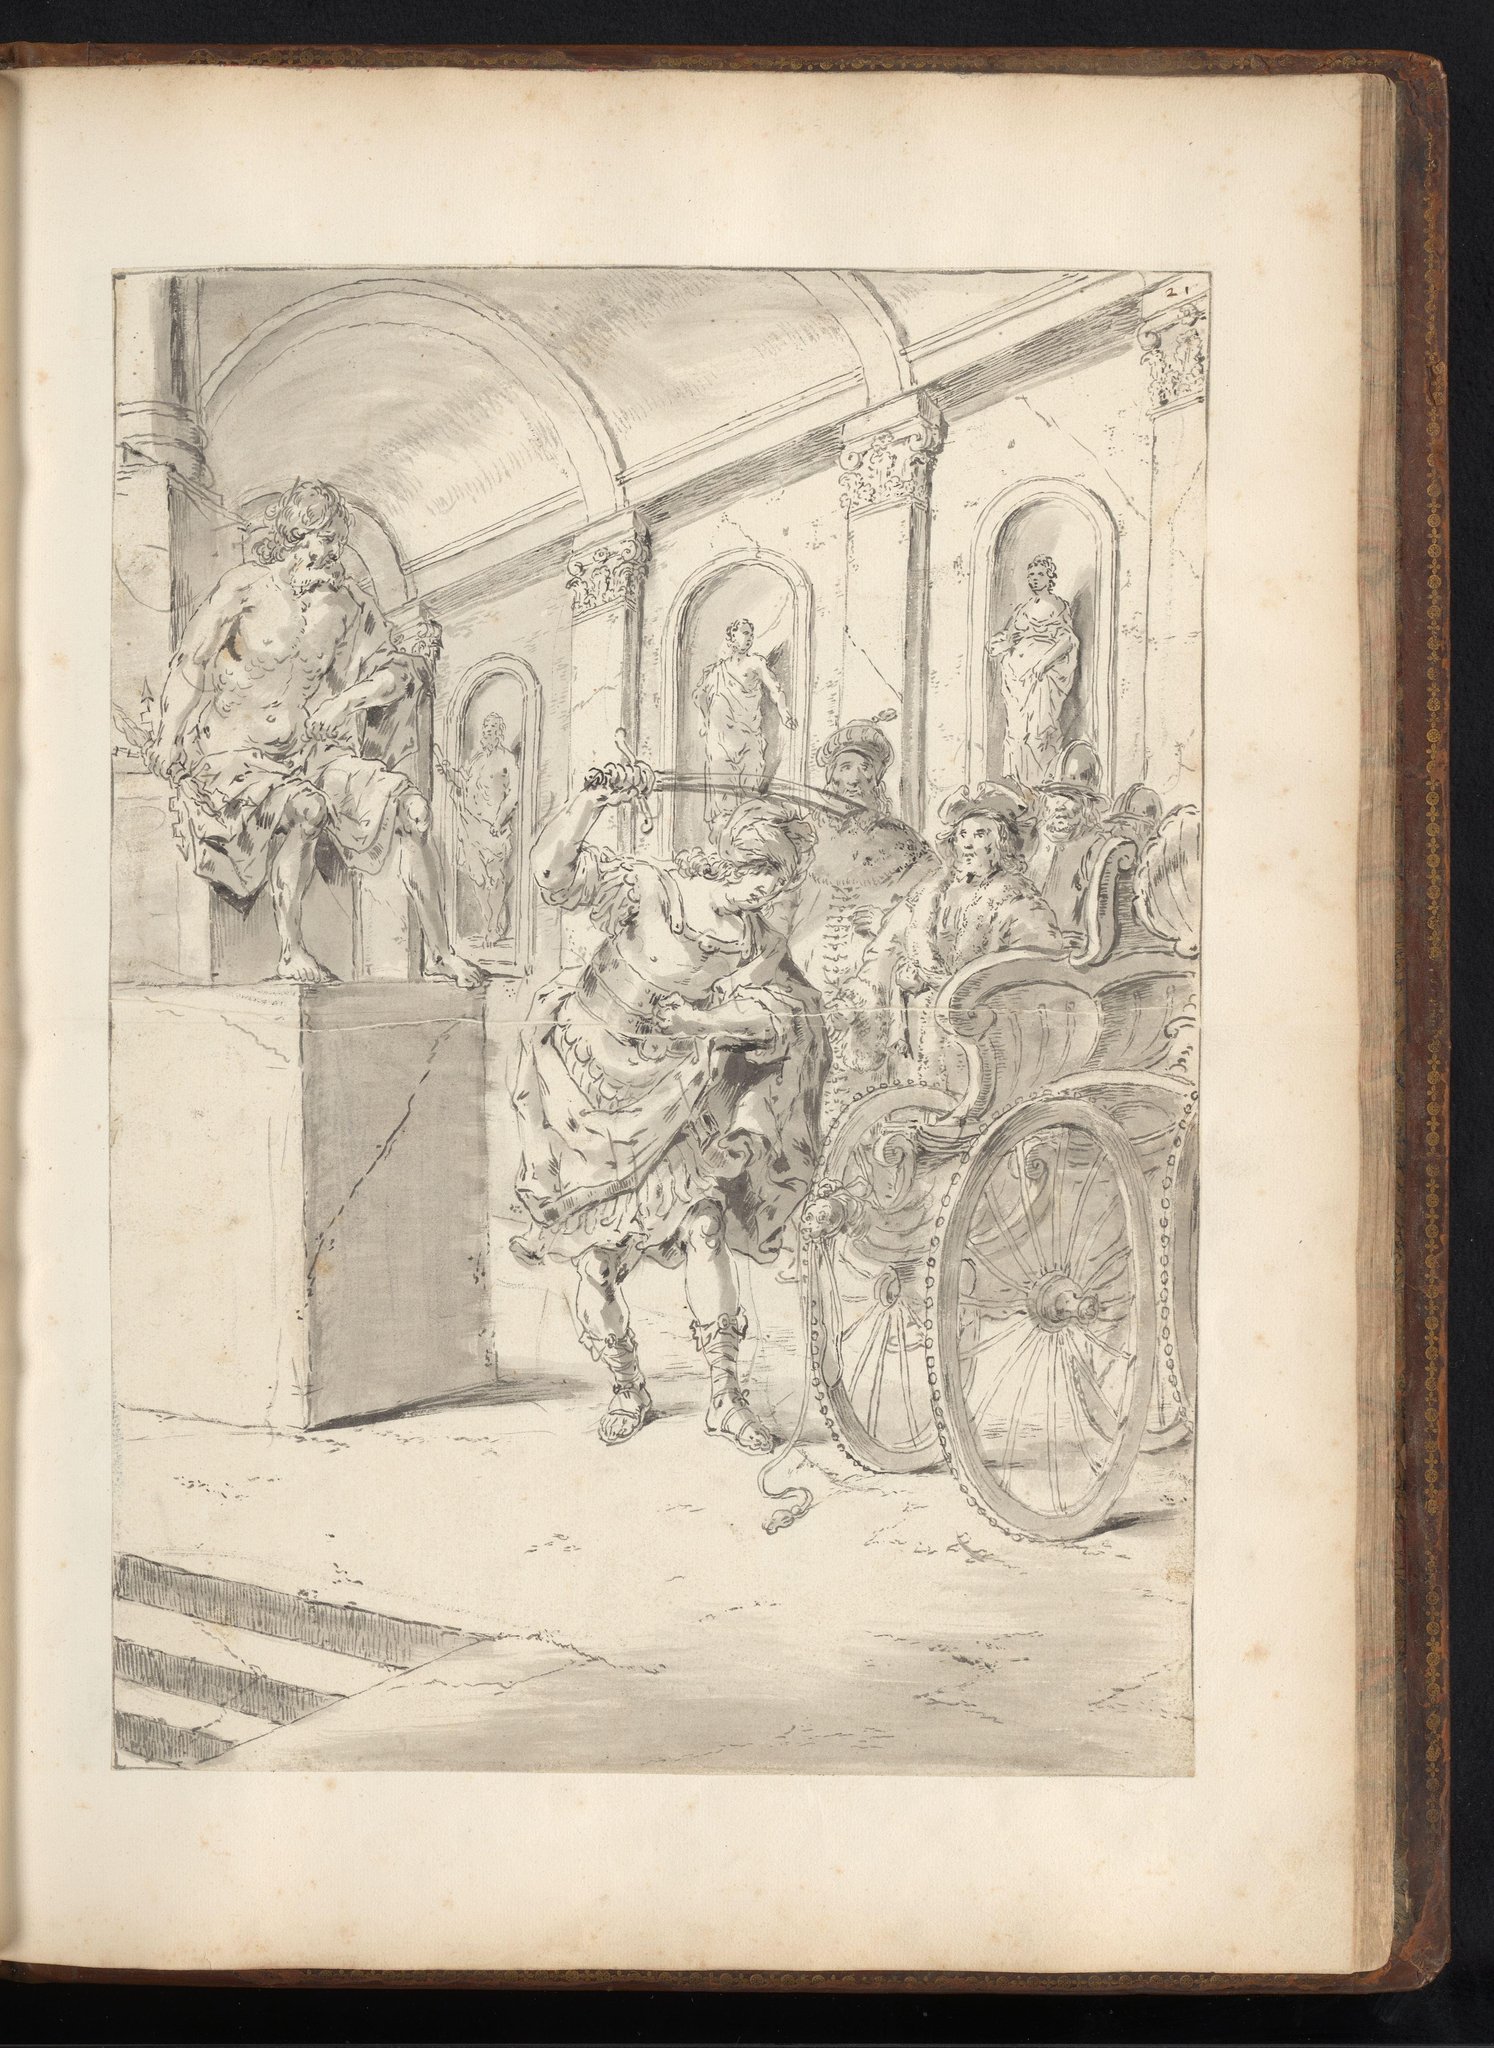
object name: album leaf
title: Vint in den tempel van Jupiter tot Gordien den wagen aan den welcken de knoop vast gemaackt was, daarmen van schreef, die desen los conde doen de ganse wereld soude besitten niet conende doen, clooftse met sijn swaart overmidt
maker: leonaert bramer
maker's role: draughtsman, painter, print maker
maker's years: 1596-1674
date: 1655-1665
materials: ink, paper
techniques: brush, pen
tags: alexander cuts the gordian knot with his sword, (story of) jupiter (zeus)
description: Alexander de Grote staat in het midden, op het punt om de Gordiaanse knoop doormidden te hakken. Op een verhoging links zit de god Jupiter. Nadat Alexander de Grote de stad Gordium had ingenomen kwam hij in de tempel van Jupiter waar zich de wagen van Gordias bevond. De dissel van de wagen was vastgemaakt met een ingewikkelde knoop. Volgens een orakel zou degene die de knoop kon ontwarren over heel Azië heersen. Het lukt Alexander niet de knoop los te krijgen, waarna hij hem met zijn zwaard doorhakt. Rechtsboven genummerd: 21. Tekening maakt deel uit van een album.